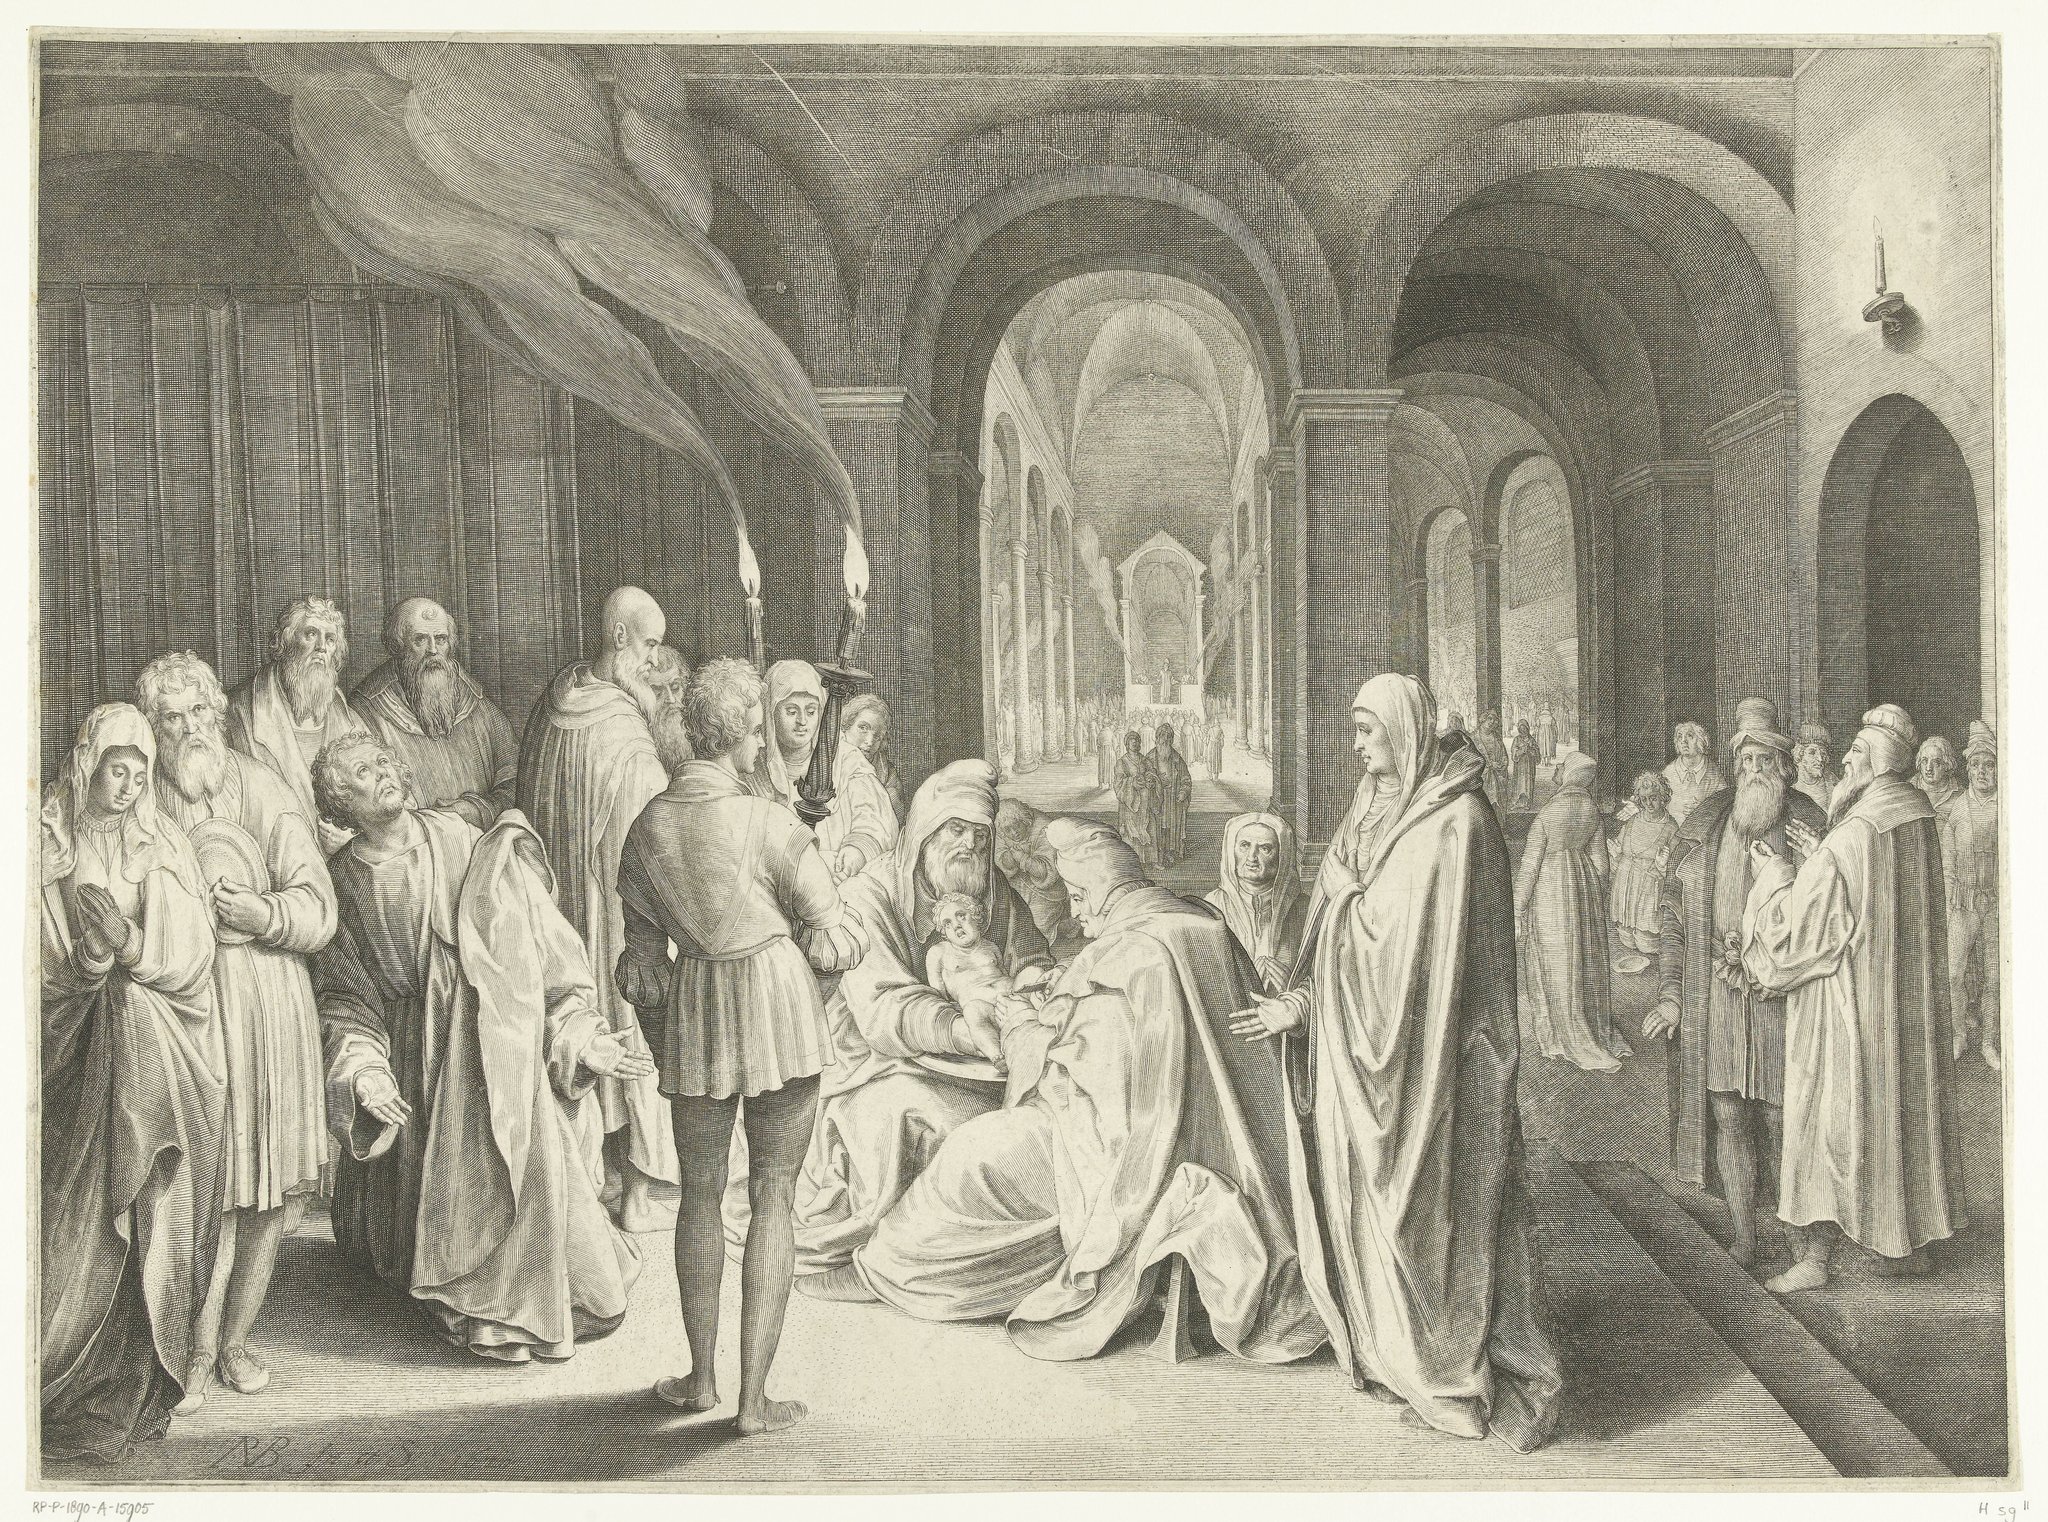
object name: print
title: Besnijdenis van Christus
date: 1620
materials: paper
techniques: engraving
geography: netherlands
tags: circumcision of the christ-child by the priest in the temple (luke 2:21)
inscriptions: collector's mark: Lugt 2228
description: De compositie van Nicolaes de Bruyn is geïnspireerd door het werk van Hendrick Goltzius.